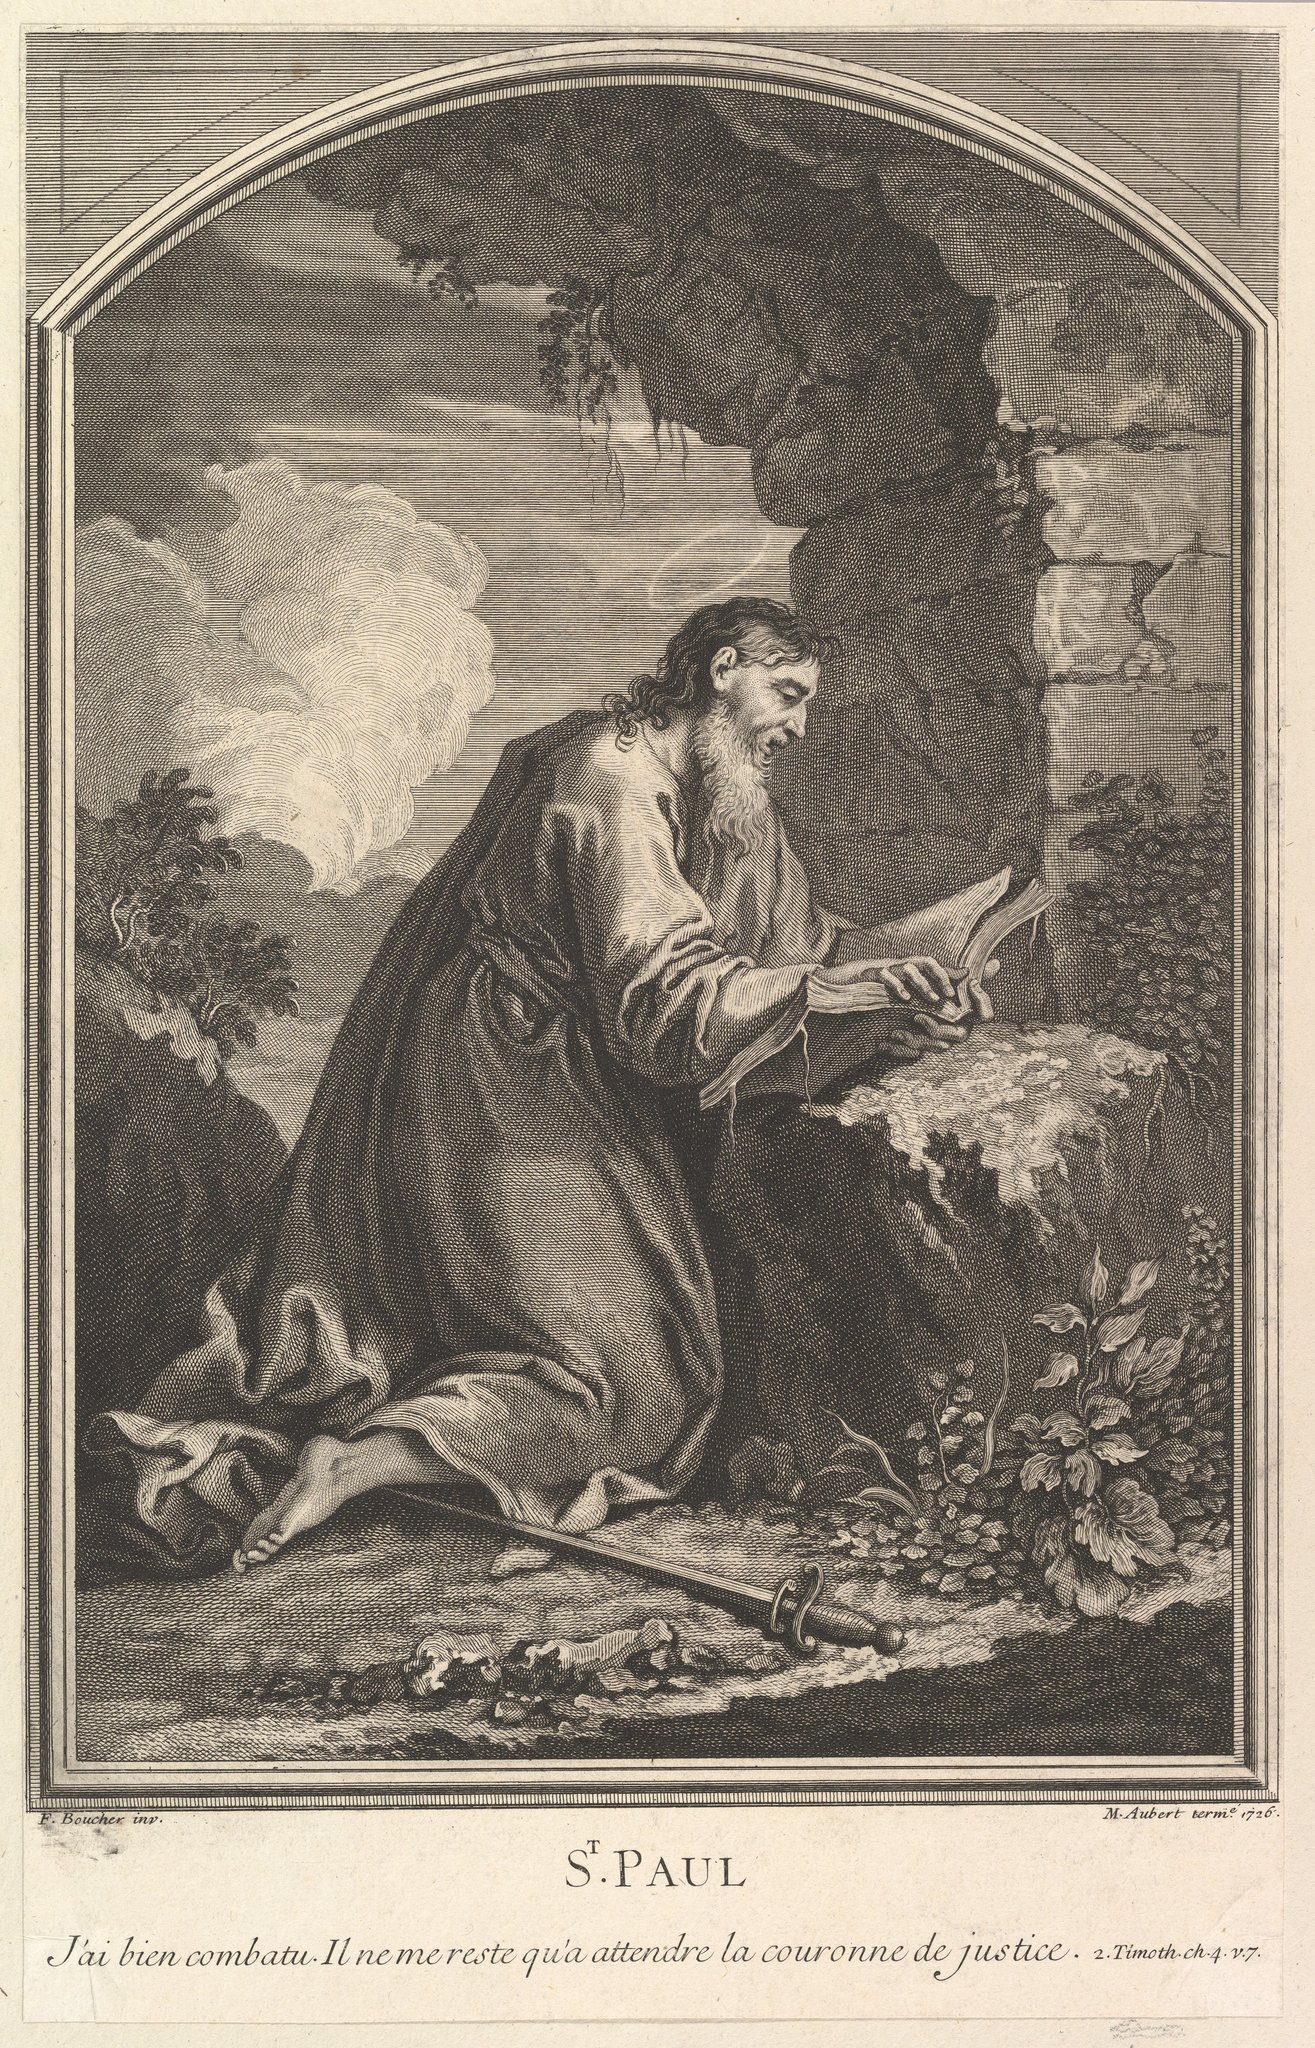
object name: print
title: Saint Paul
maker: michel aubert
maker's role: artist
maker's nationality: french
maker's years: 1700-1757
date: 1726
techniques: engraving, etching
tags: reading,saint paul